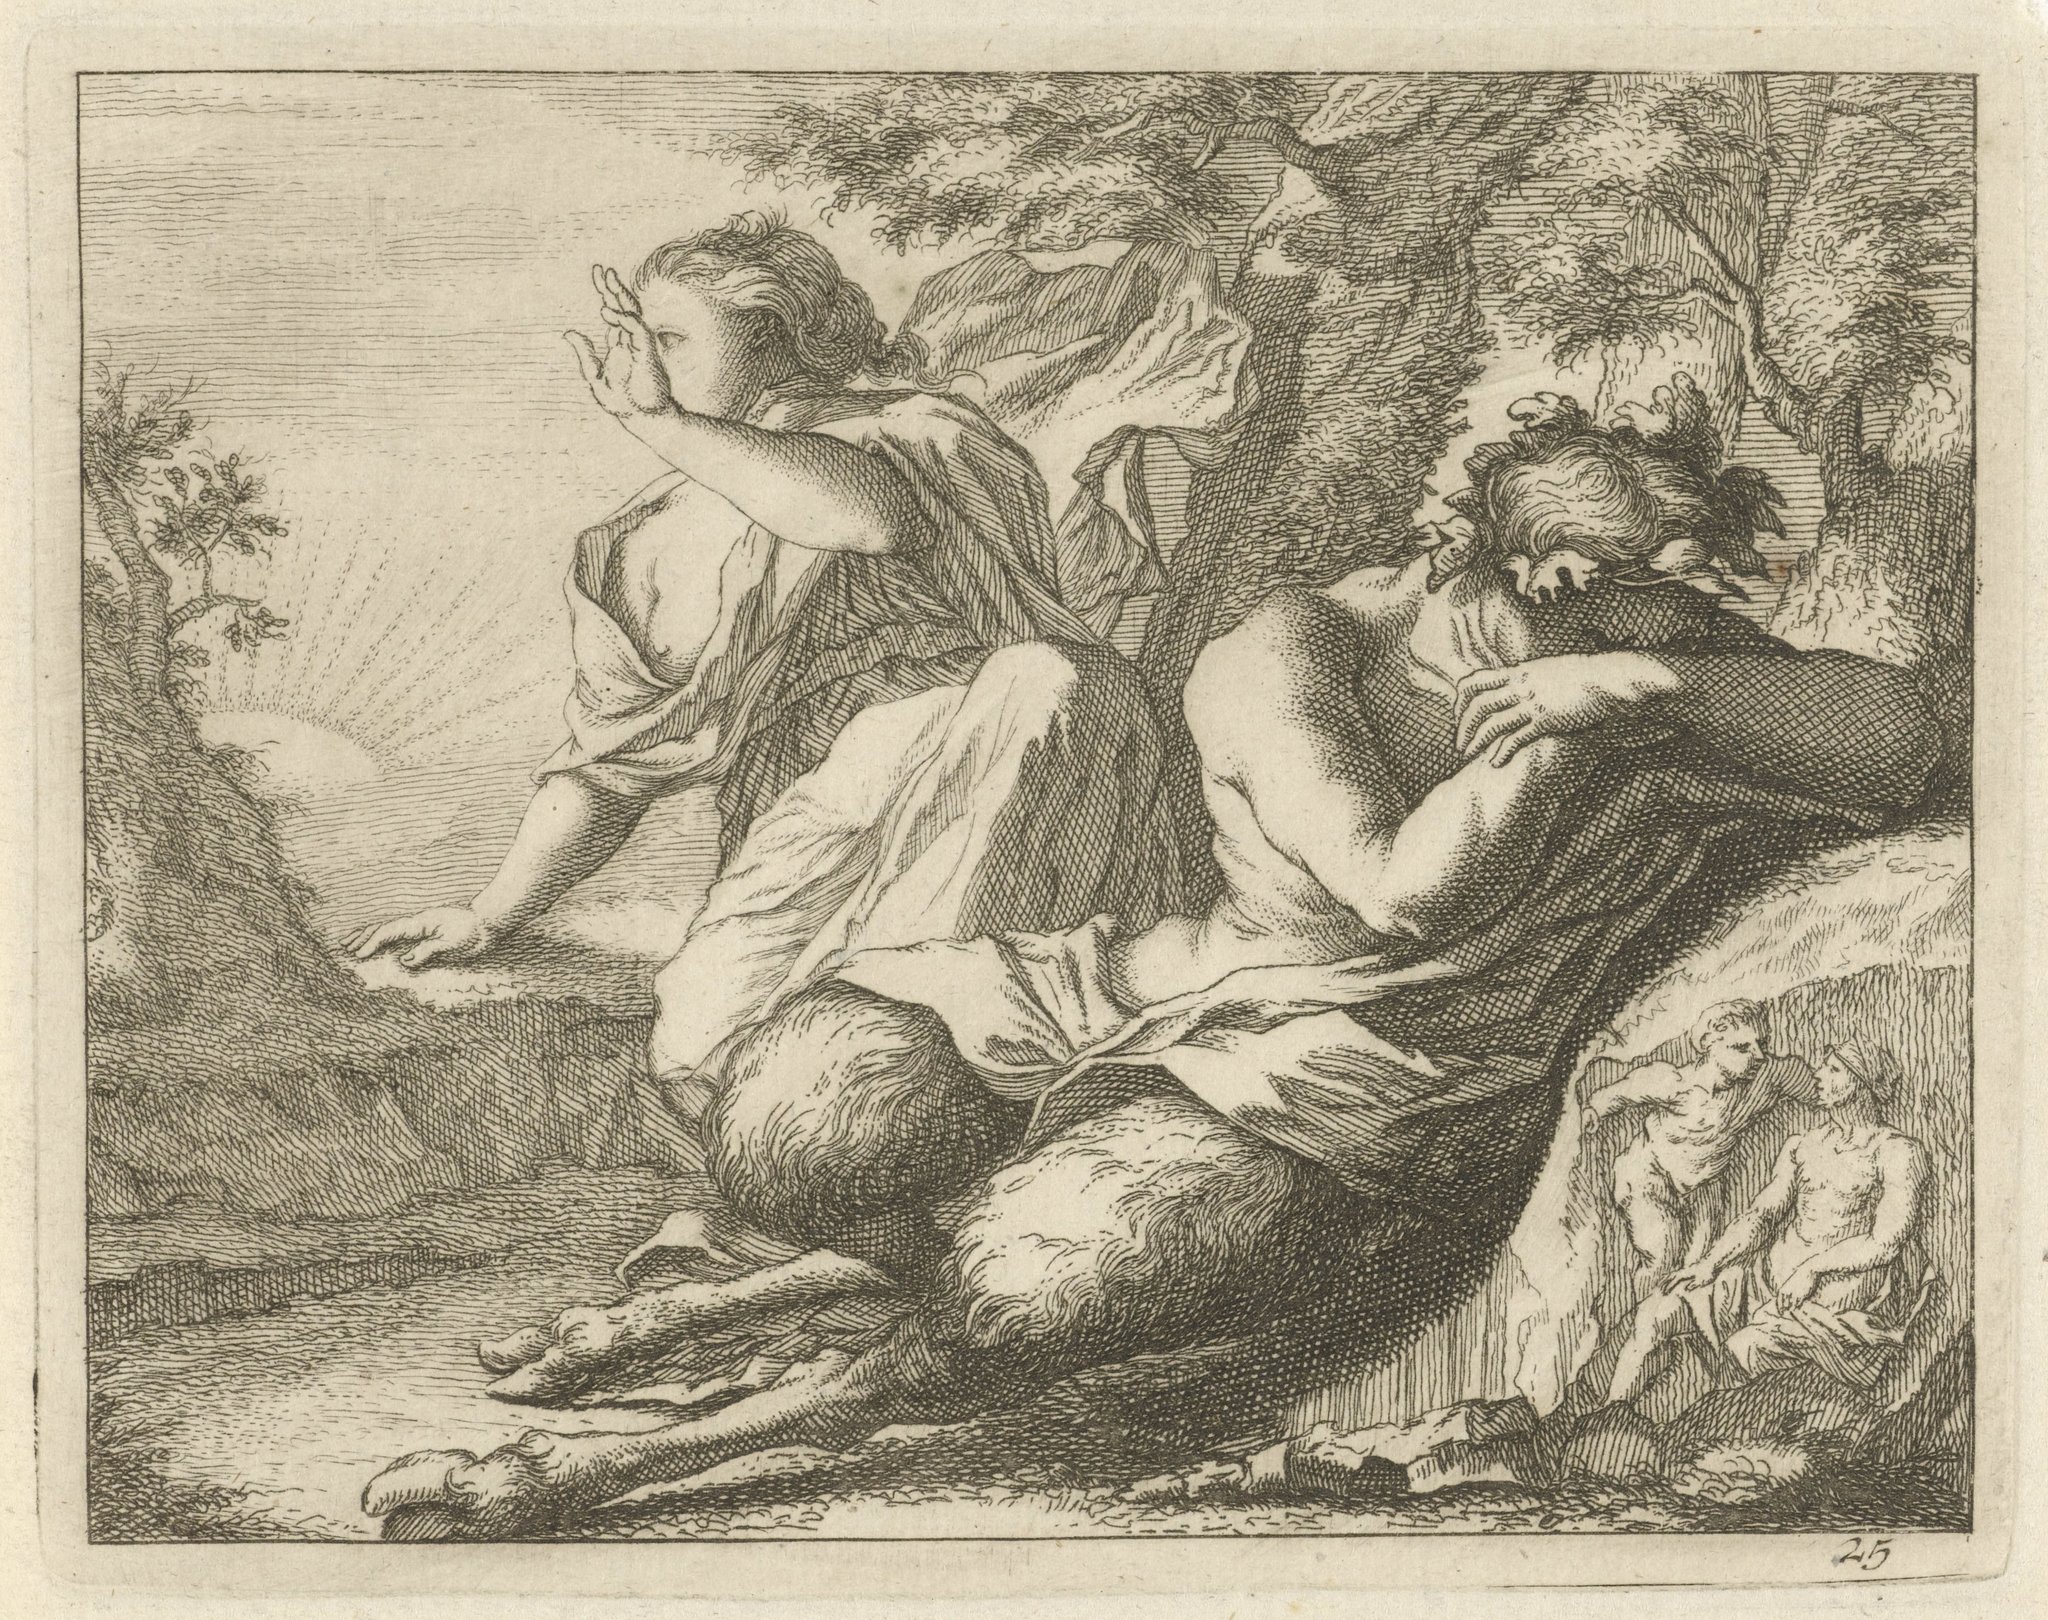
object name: print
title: Sater en vrouwfiguur bedekken de ogen tegen zonlicht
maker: Anonymous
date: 1700-1750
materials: paper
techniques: etching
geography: northern netherlands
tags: sunrise, satyr(s) (in general)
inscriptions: collector's mark: Lugt 2228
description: Een sater en een vrouwfiguur in een landschap bedekken de ogen tegen licht van de opkomende zon. De sater ligt leunend tegen een steen met daarop een haut-relief. Kopie naar de prent van Houbraken uit deel 2 van een serie prenten met zinnebeelden.